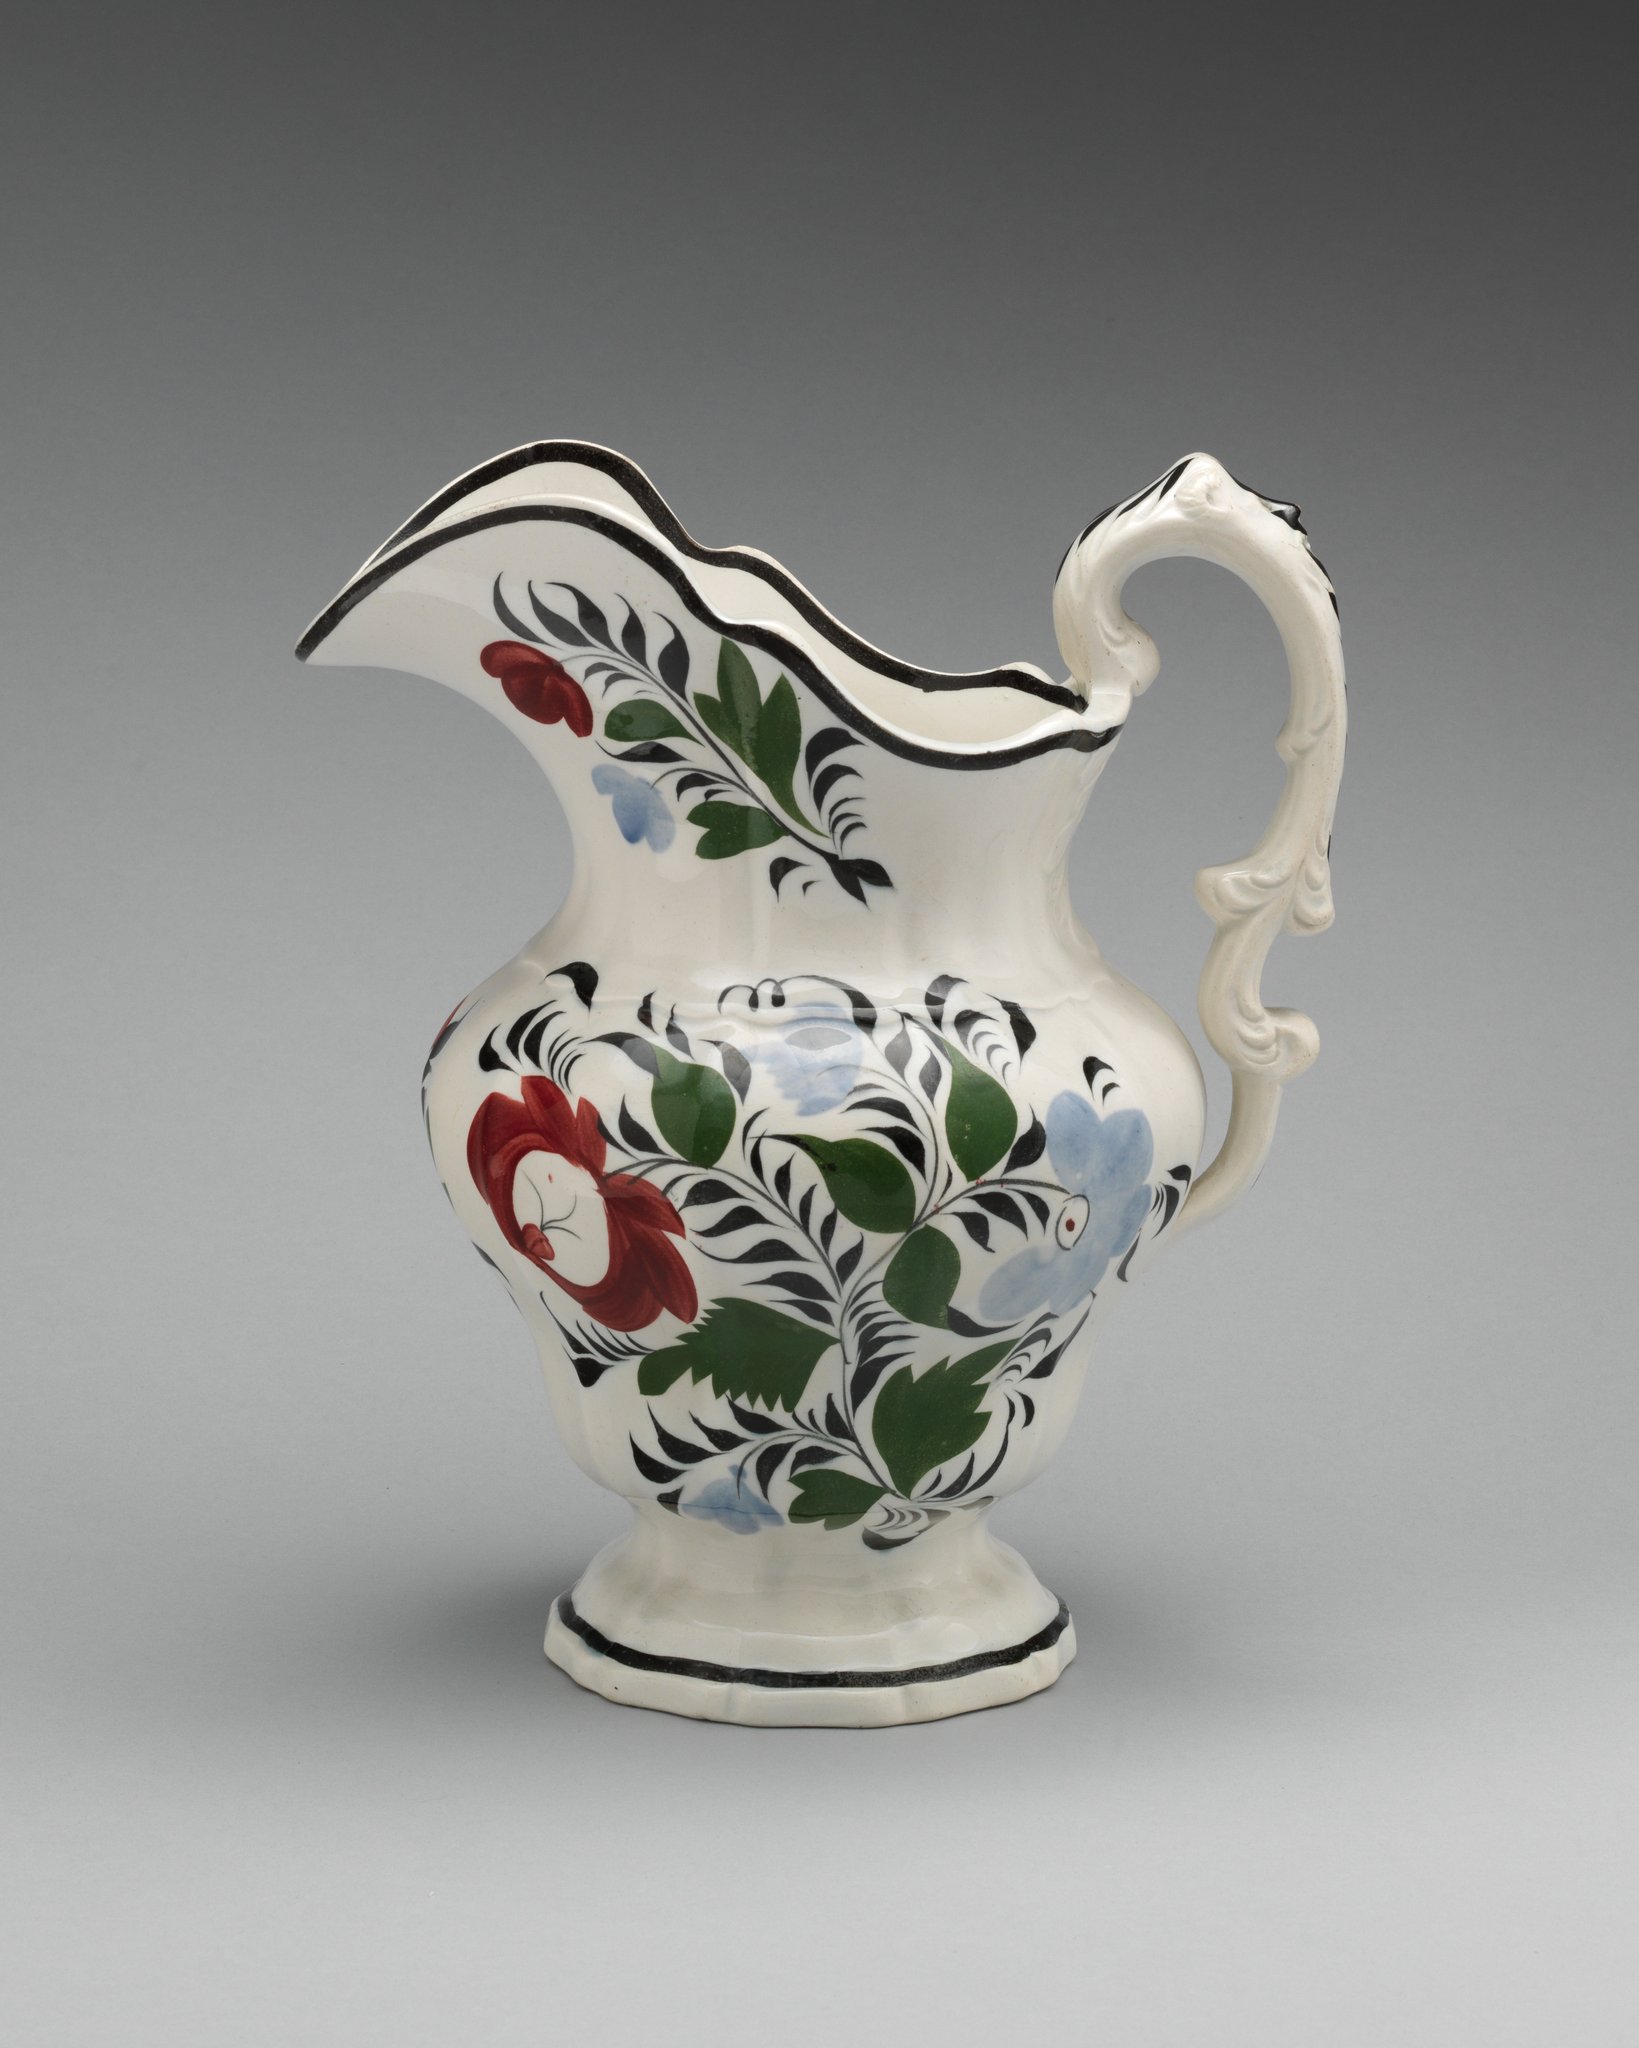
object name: jug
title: Jug (part of a set)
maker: william adams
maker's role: maker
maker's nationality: british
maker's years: 1798-1865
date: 1701-1900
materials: earthenware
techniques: glazing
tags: flowers